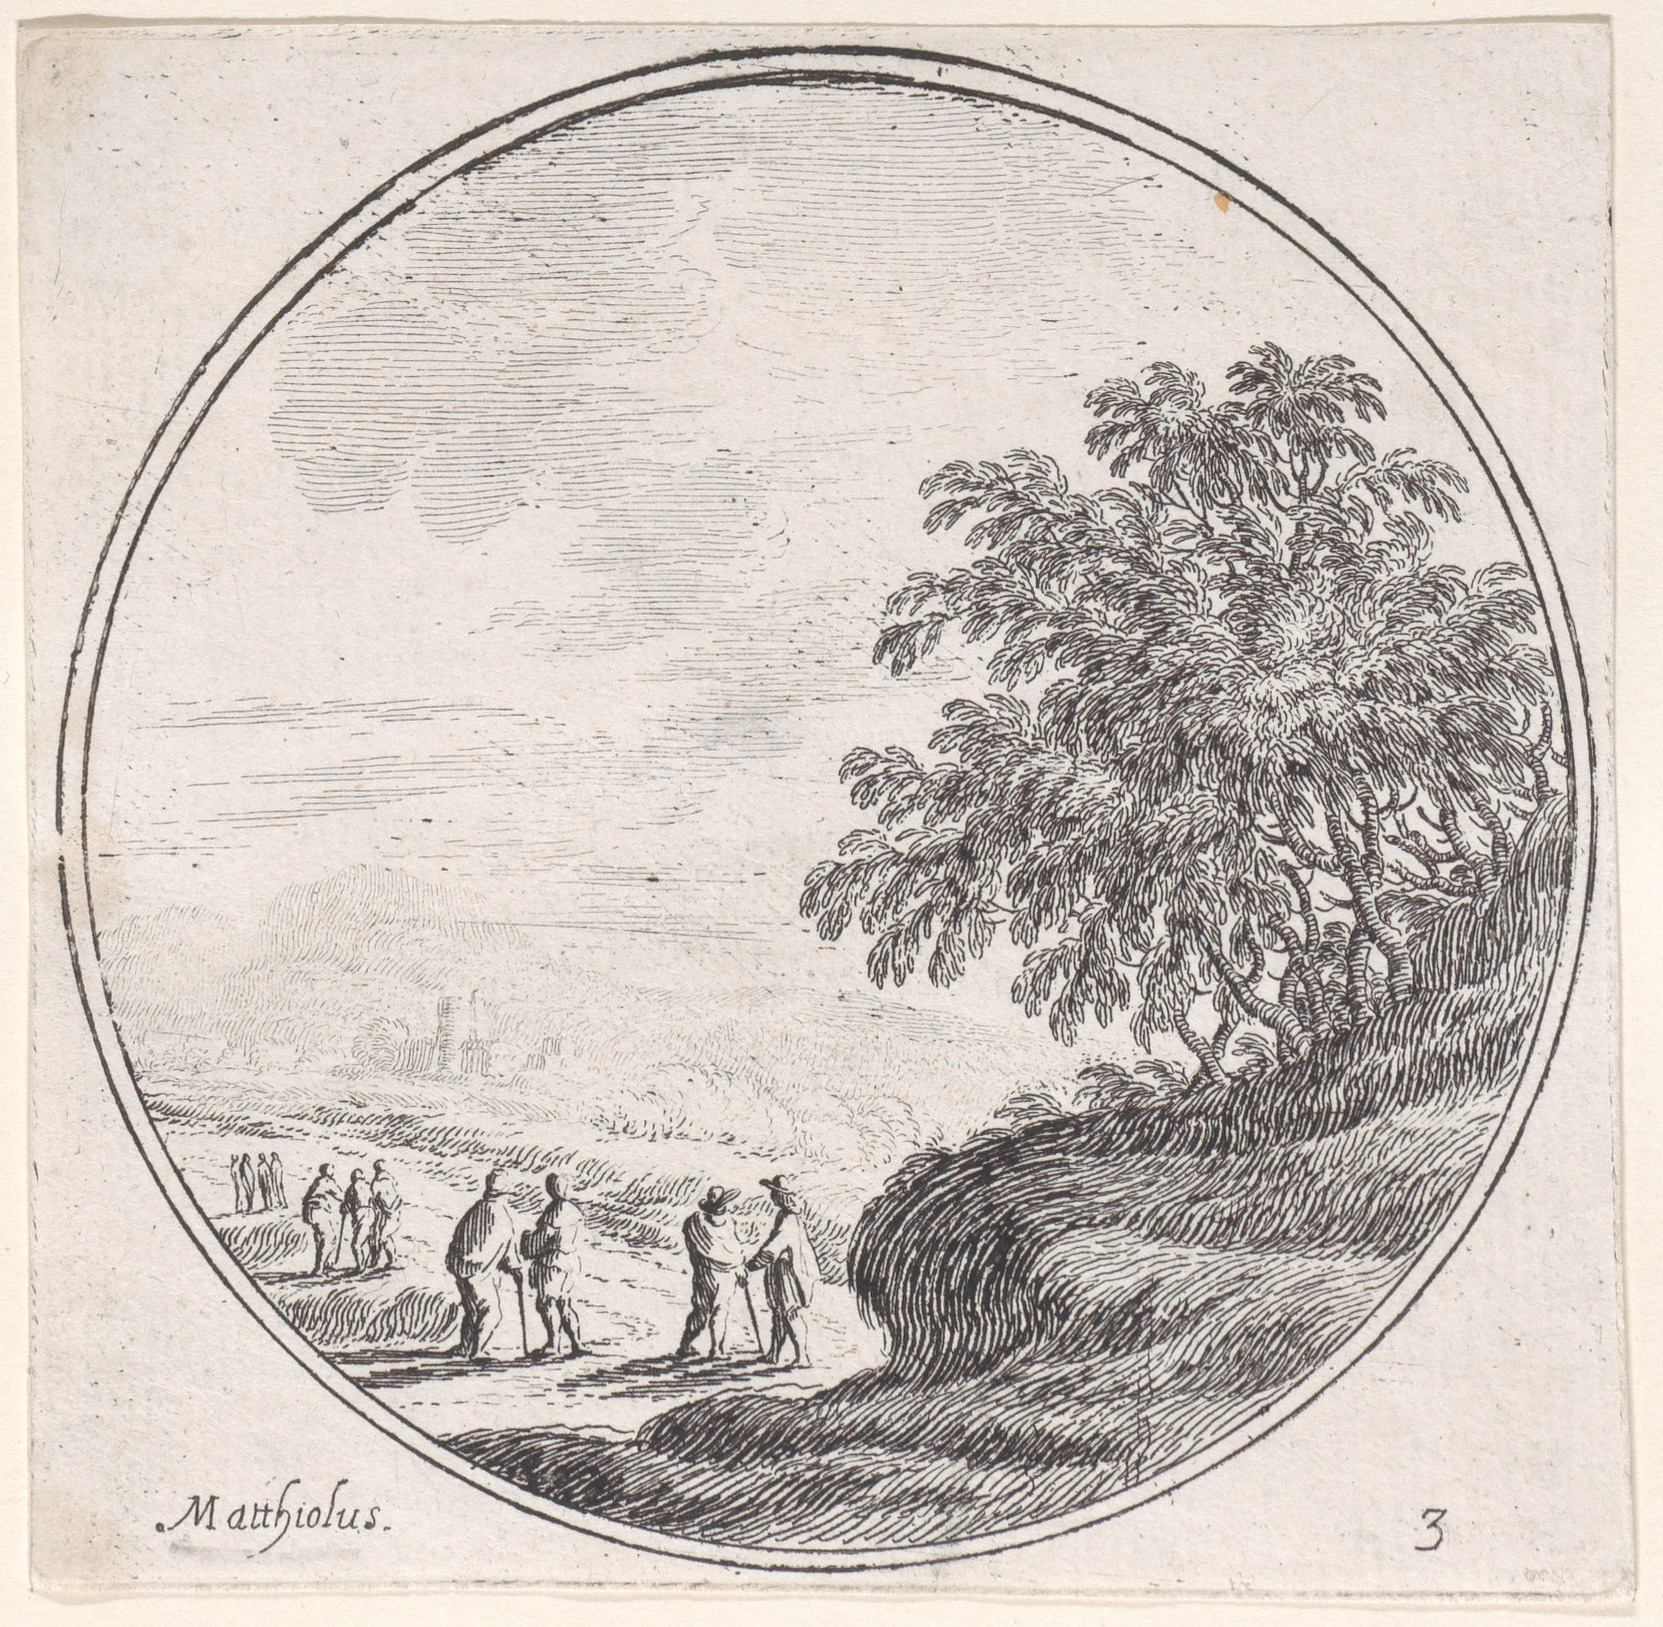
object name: print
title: Plate 3: figures in a landscape at lower left, trees at right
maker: lodovico mattioli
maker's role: artist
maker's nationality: italian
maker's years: 1662-1747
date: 1680-1747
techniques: etching